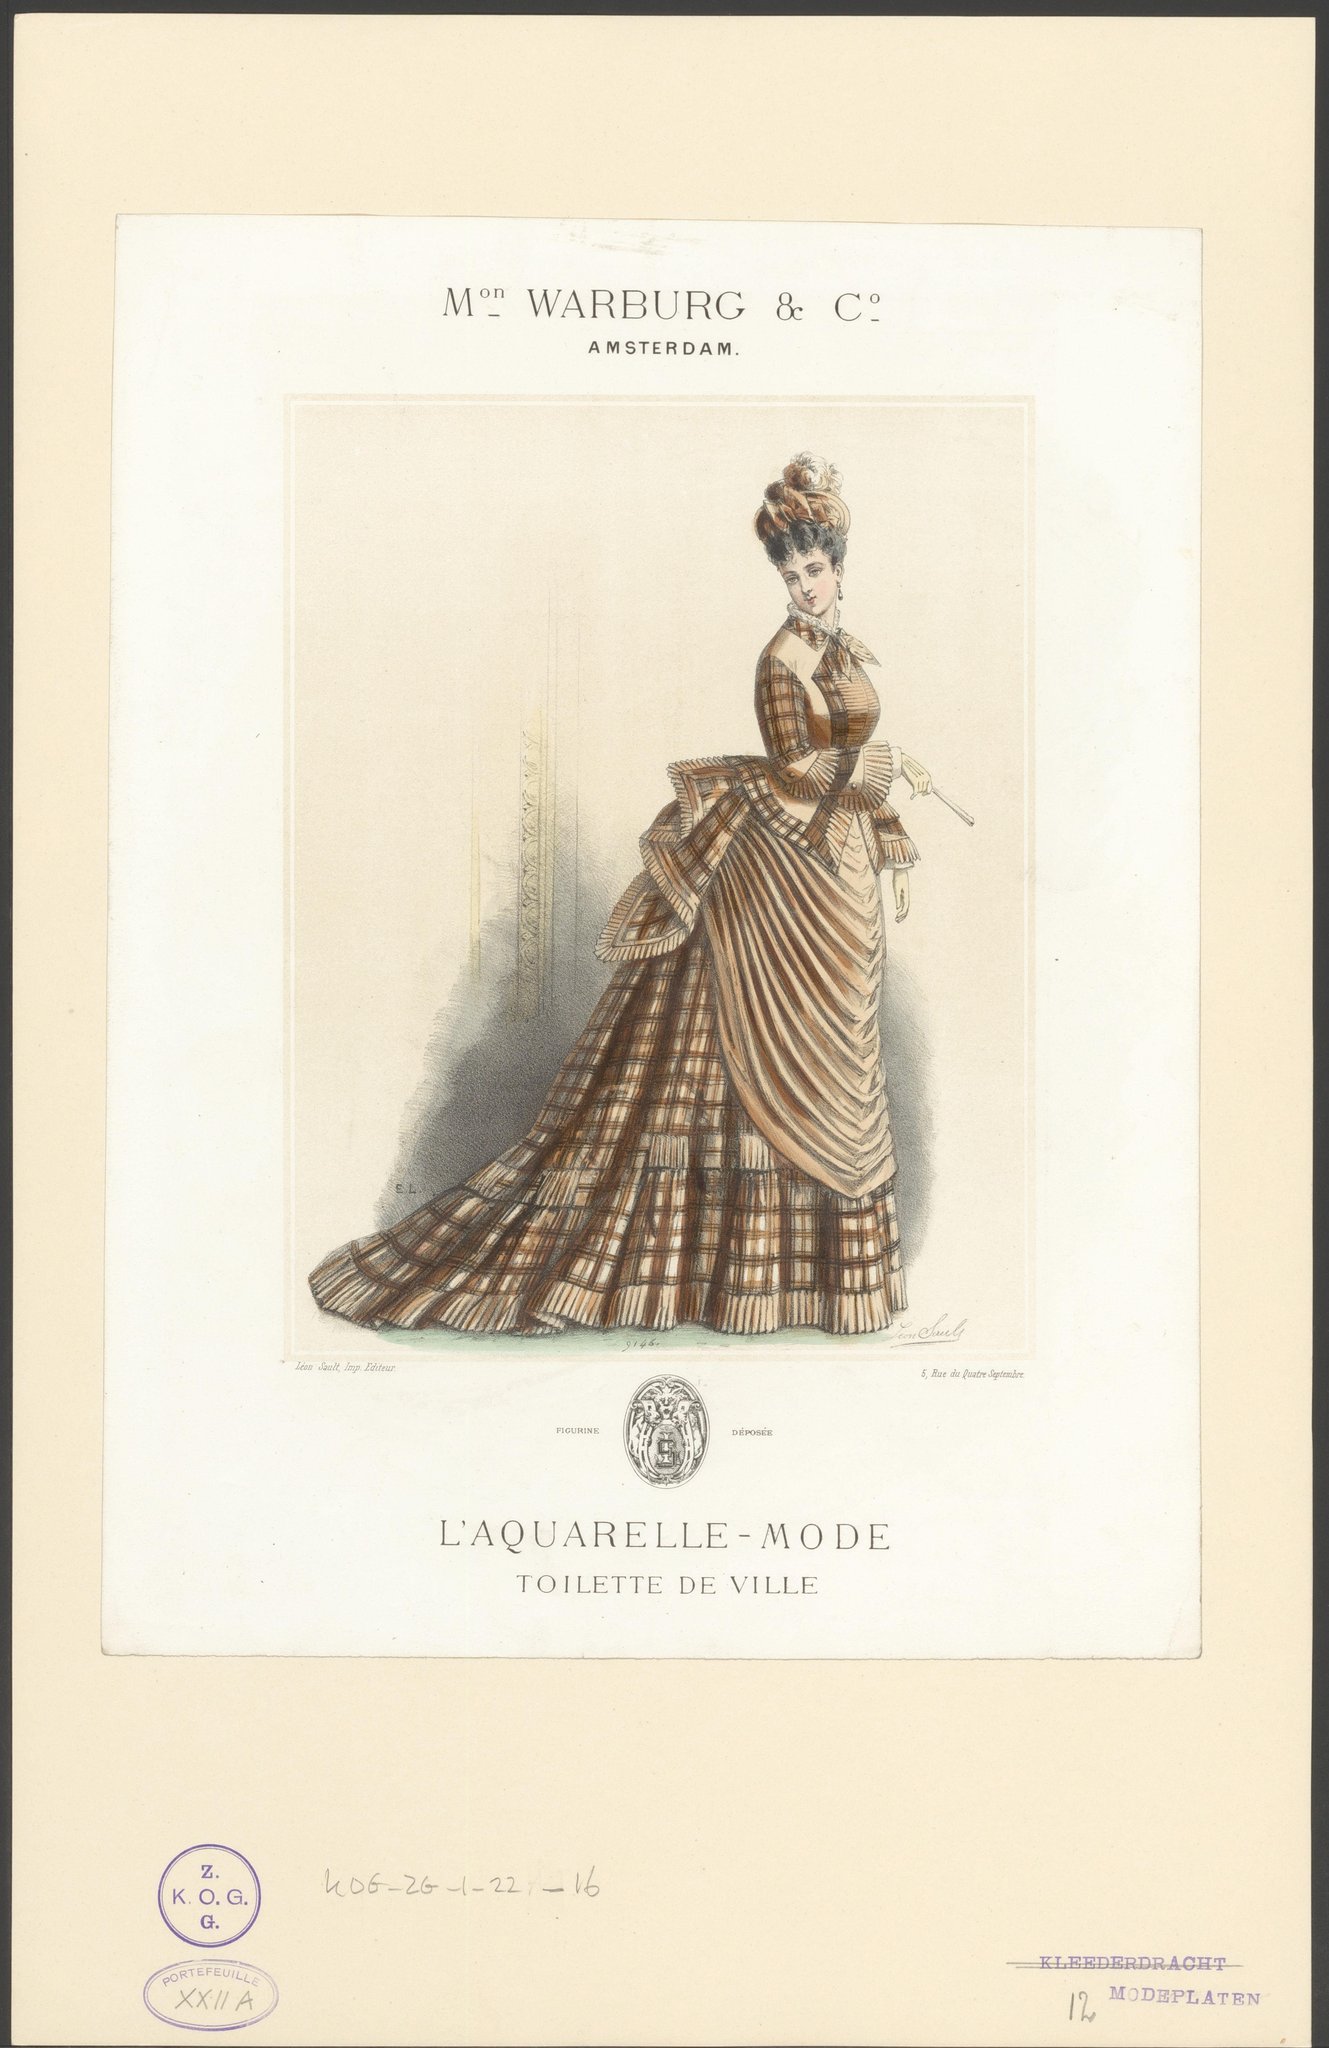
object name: print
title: Toilette de Ville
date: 1875-1886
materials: lacquer, paper, watercolor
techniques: hand coloring, lacquer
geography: paris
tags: fashion plates, clothes, costume (+ women's clothes), dress, gown (+ women's clothes)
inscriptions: collector's mark: Lugt 1641, collector's mark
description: Vrouw in bruine japon, staande naar rechts, waaier in de hand. Met vermelding van 'Mon. Warburg & Co. Amsterdam'. Prent uit het modetijdschrift L'Aquarelle-Mode (1866-1892). nr. 9146. Onderwerpsrubrieken binnen de Atlas Zeden en Gewoonten: De Kleeding, Modeplaten.